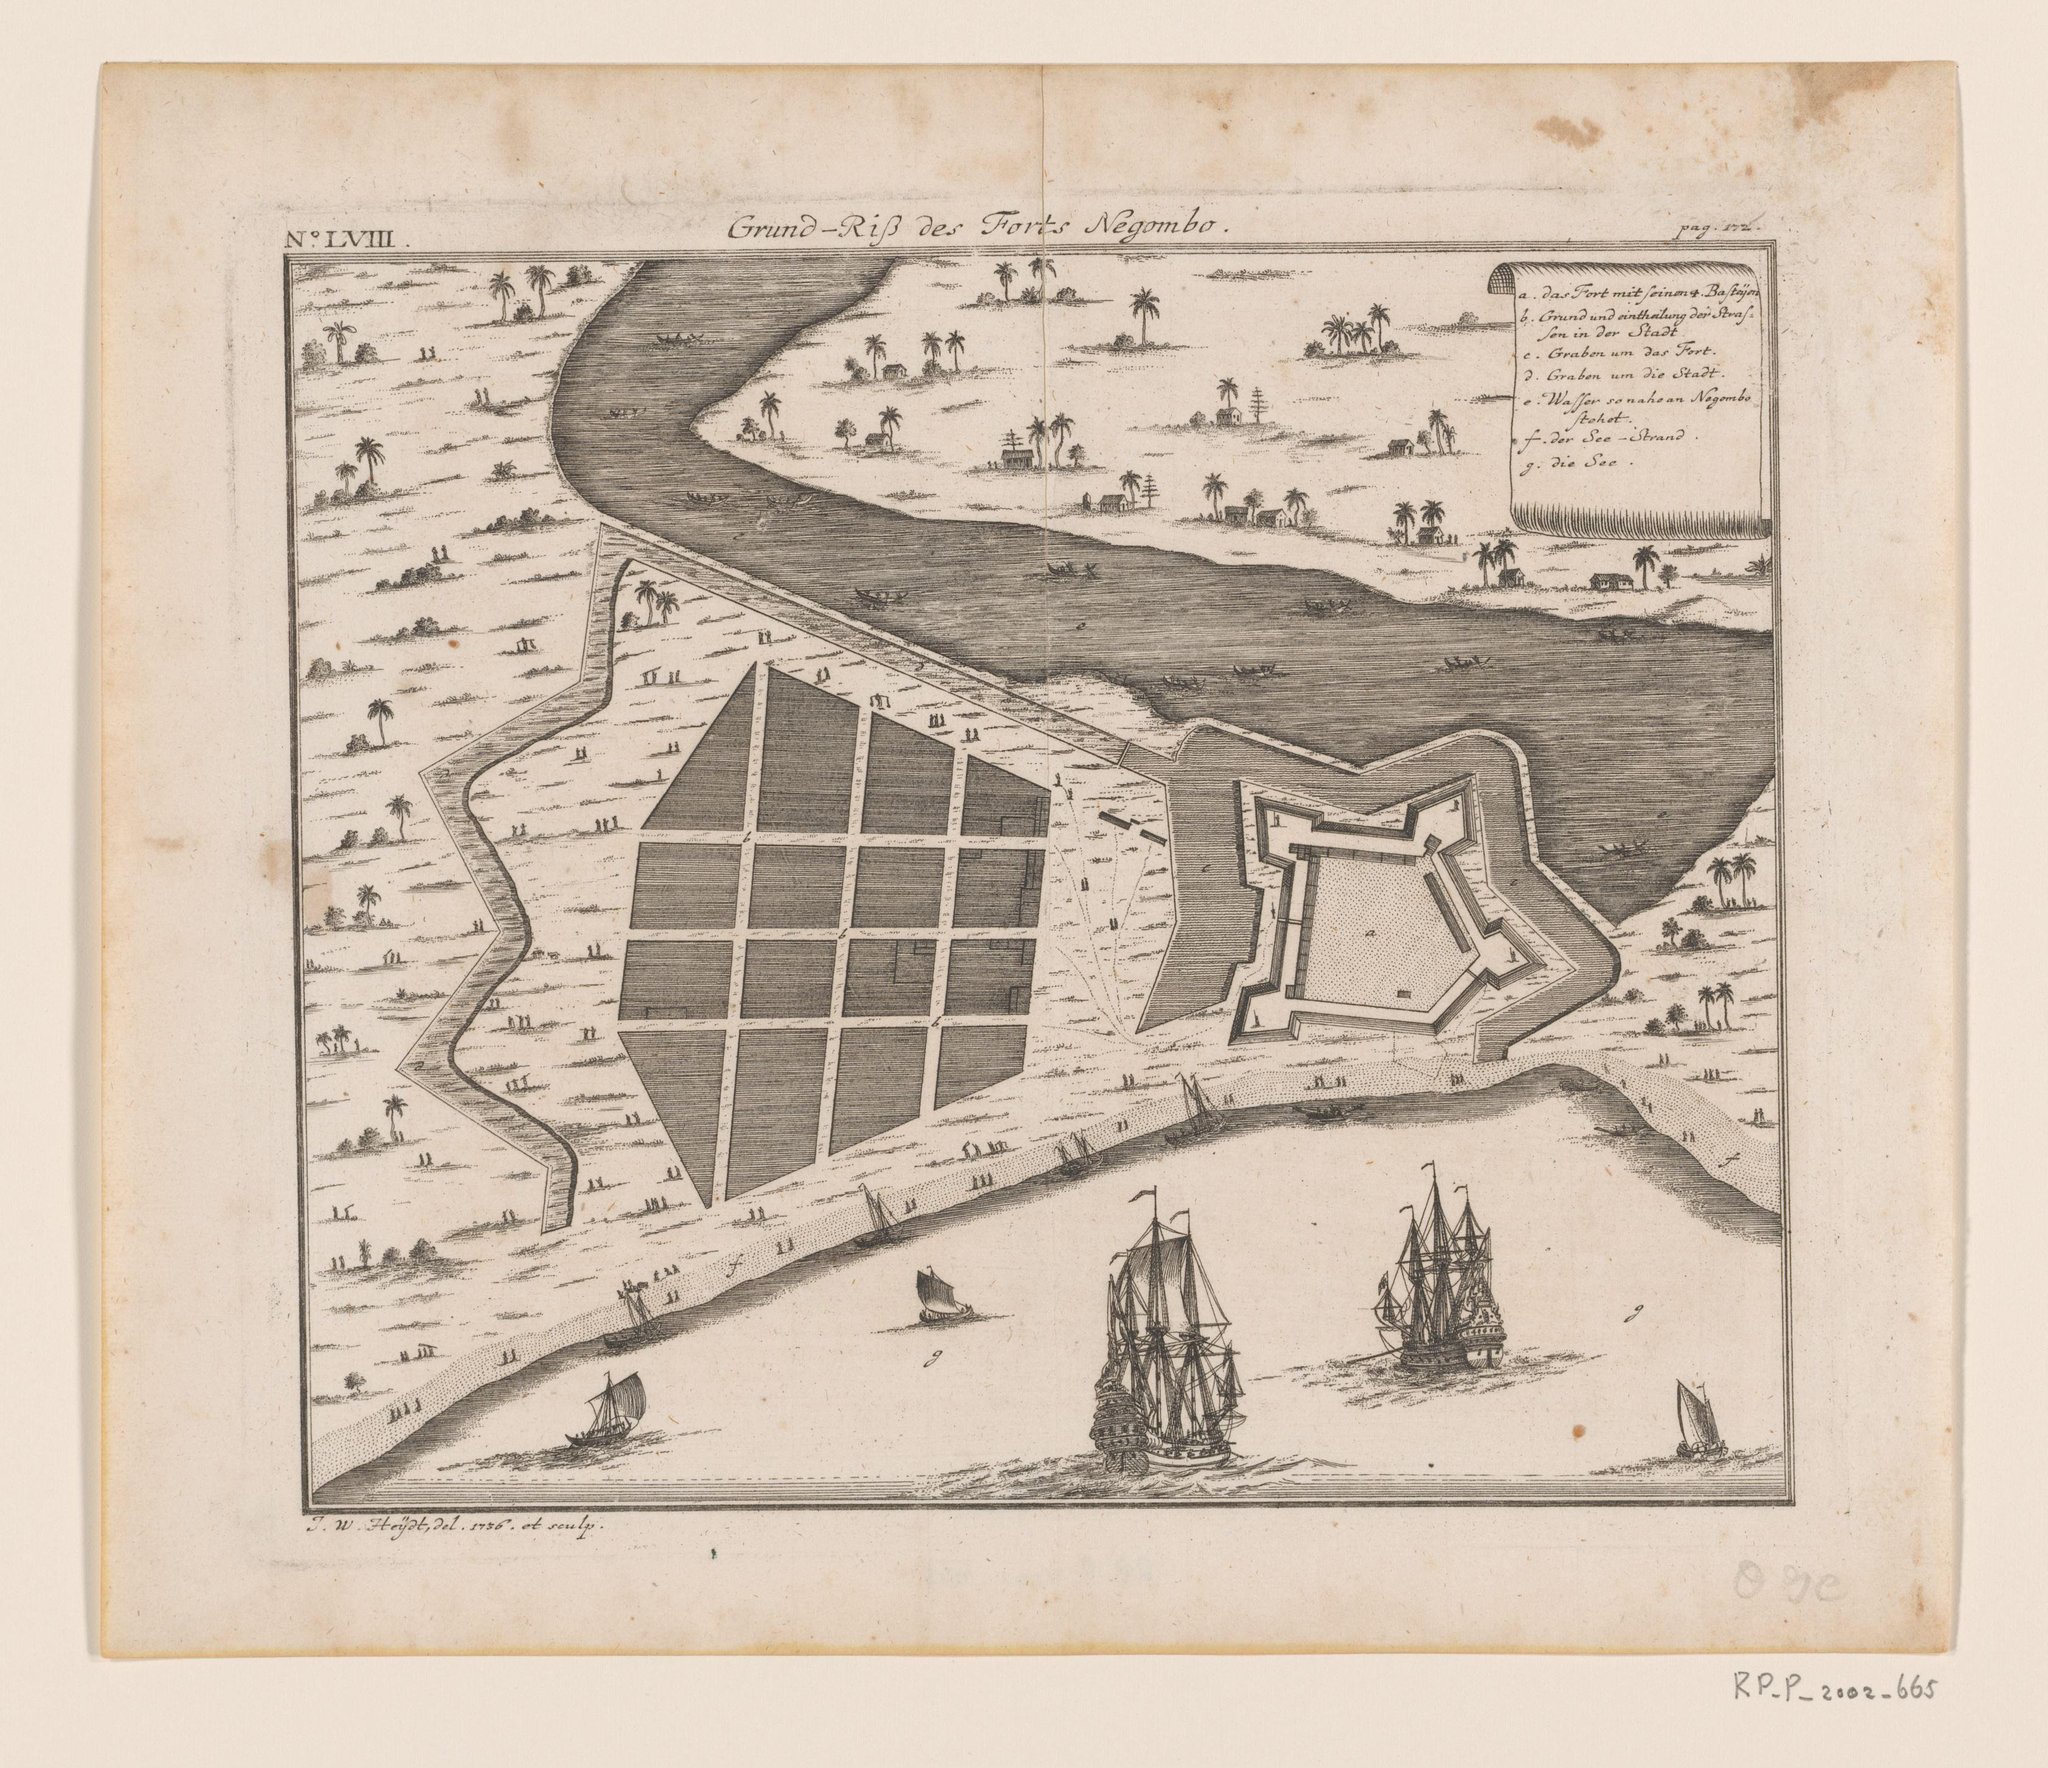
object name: print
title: Grund-Riss des Forts Negombo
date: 1736-1744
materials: paper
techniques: etching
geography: nuremberg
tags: fortress, plan ~ architecture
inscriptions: collector's mark: Lugt 2228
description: Prent ook gebruikt in: Heydt, Johann Wolffgang. Allerneuester geographisch- und topographischer Schau-platz (...). Neurenberg: erven Johann Baptista Homann, 1744.